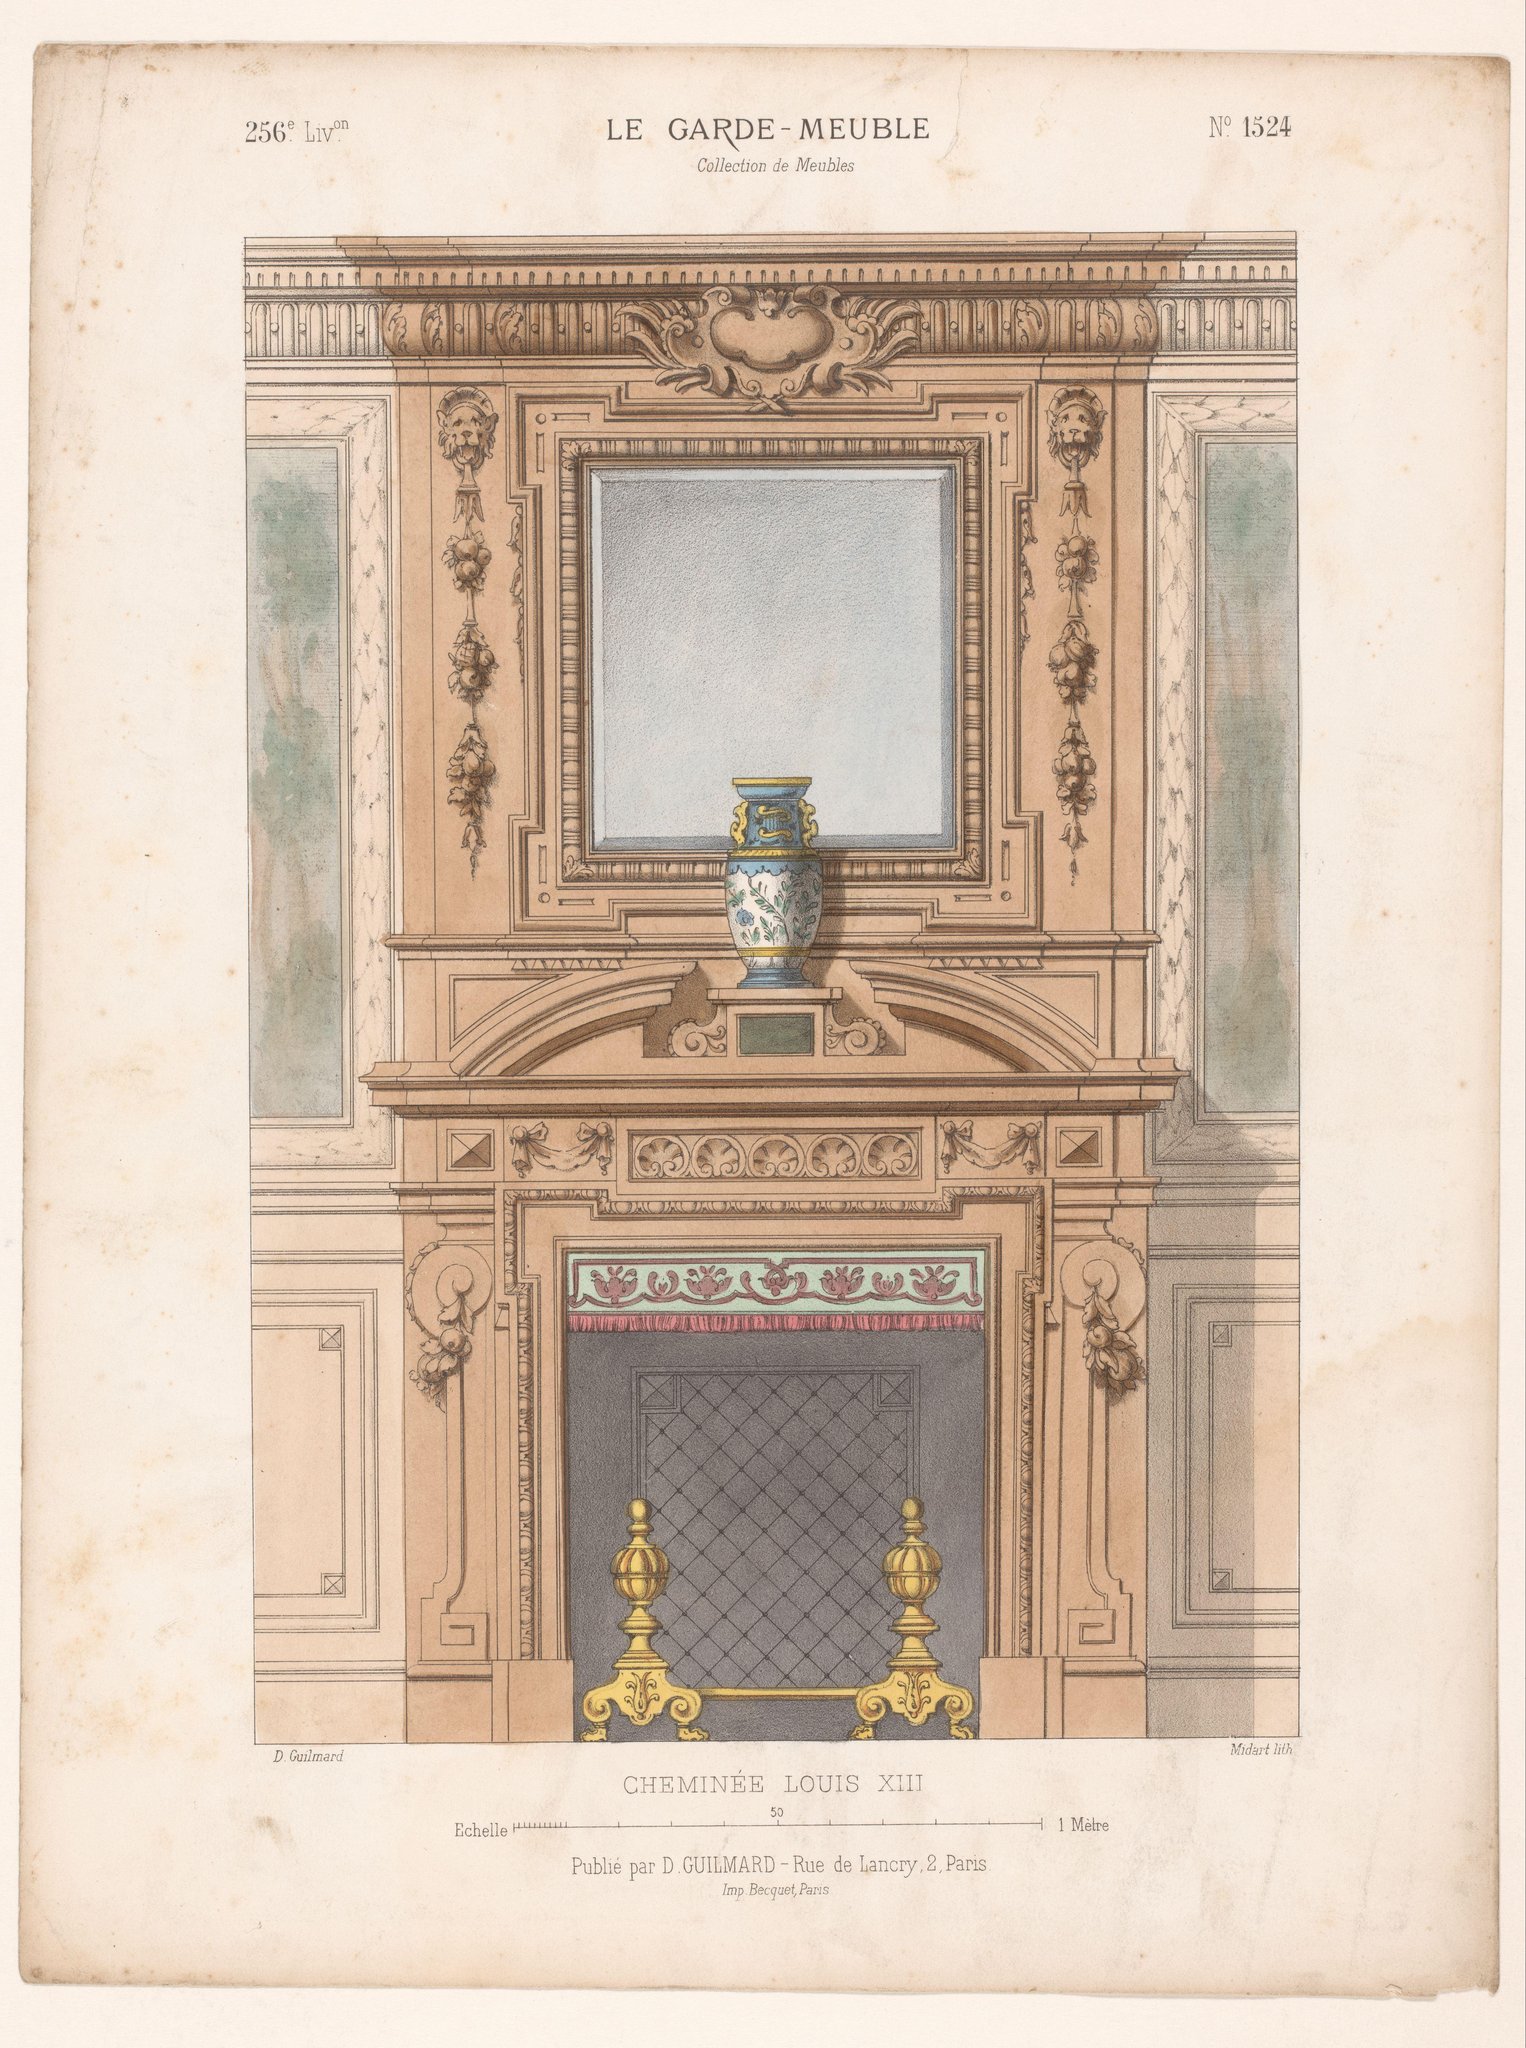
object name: print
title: Schouw met spiegel en vaas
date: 1839-1885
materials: paper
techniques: hand coloring, lithograph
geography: paris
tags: chimney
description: Ieder Livraison in de serie Le Garde-Meuble bevat negen platen: drie 'sièges' (zitmeubels), drie 'meubles' (diverse meubels zoals tafels en kasten) en drie 'tentures' (gordijnen en draperieën).